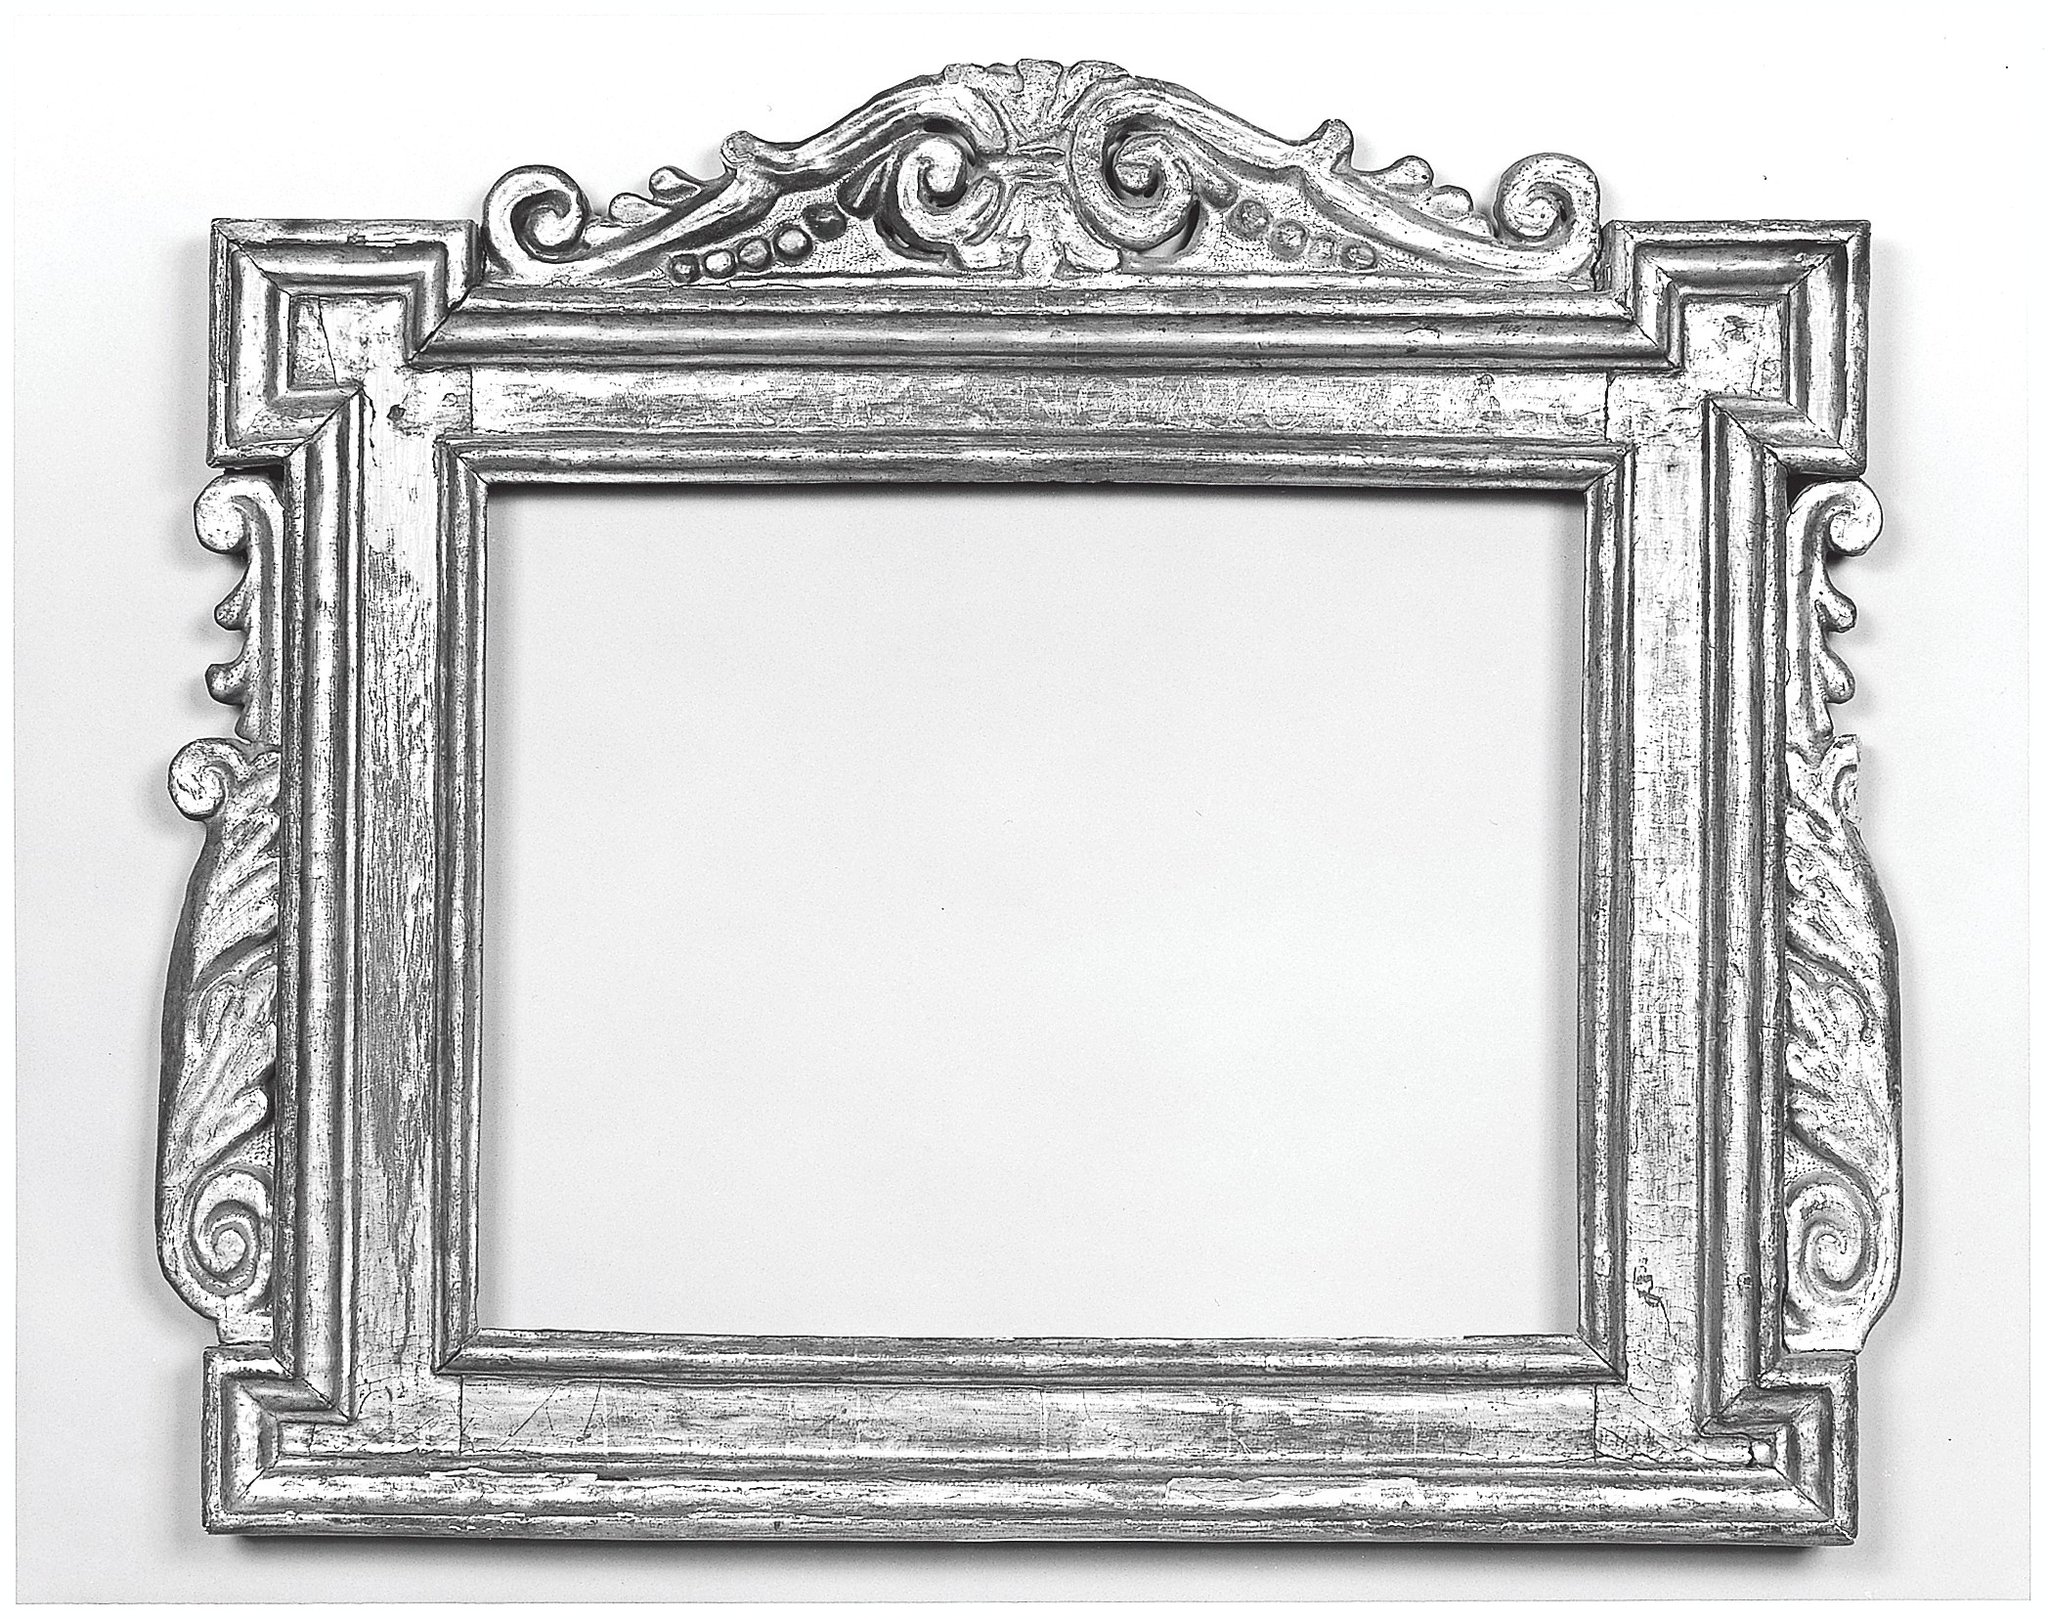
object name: frame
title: Cassetta frame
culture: italian, lombardy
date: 1634-1666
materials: wood